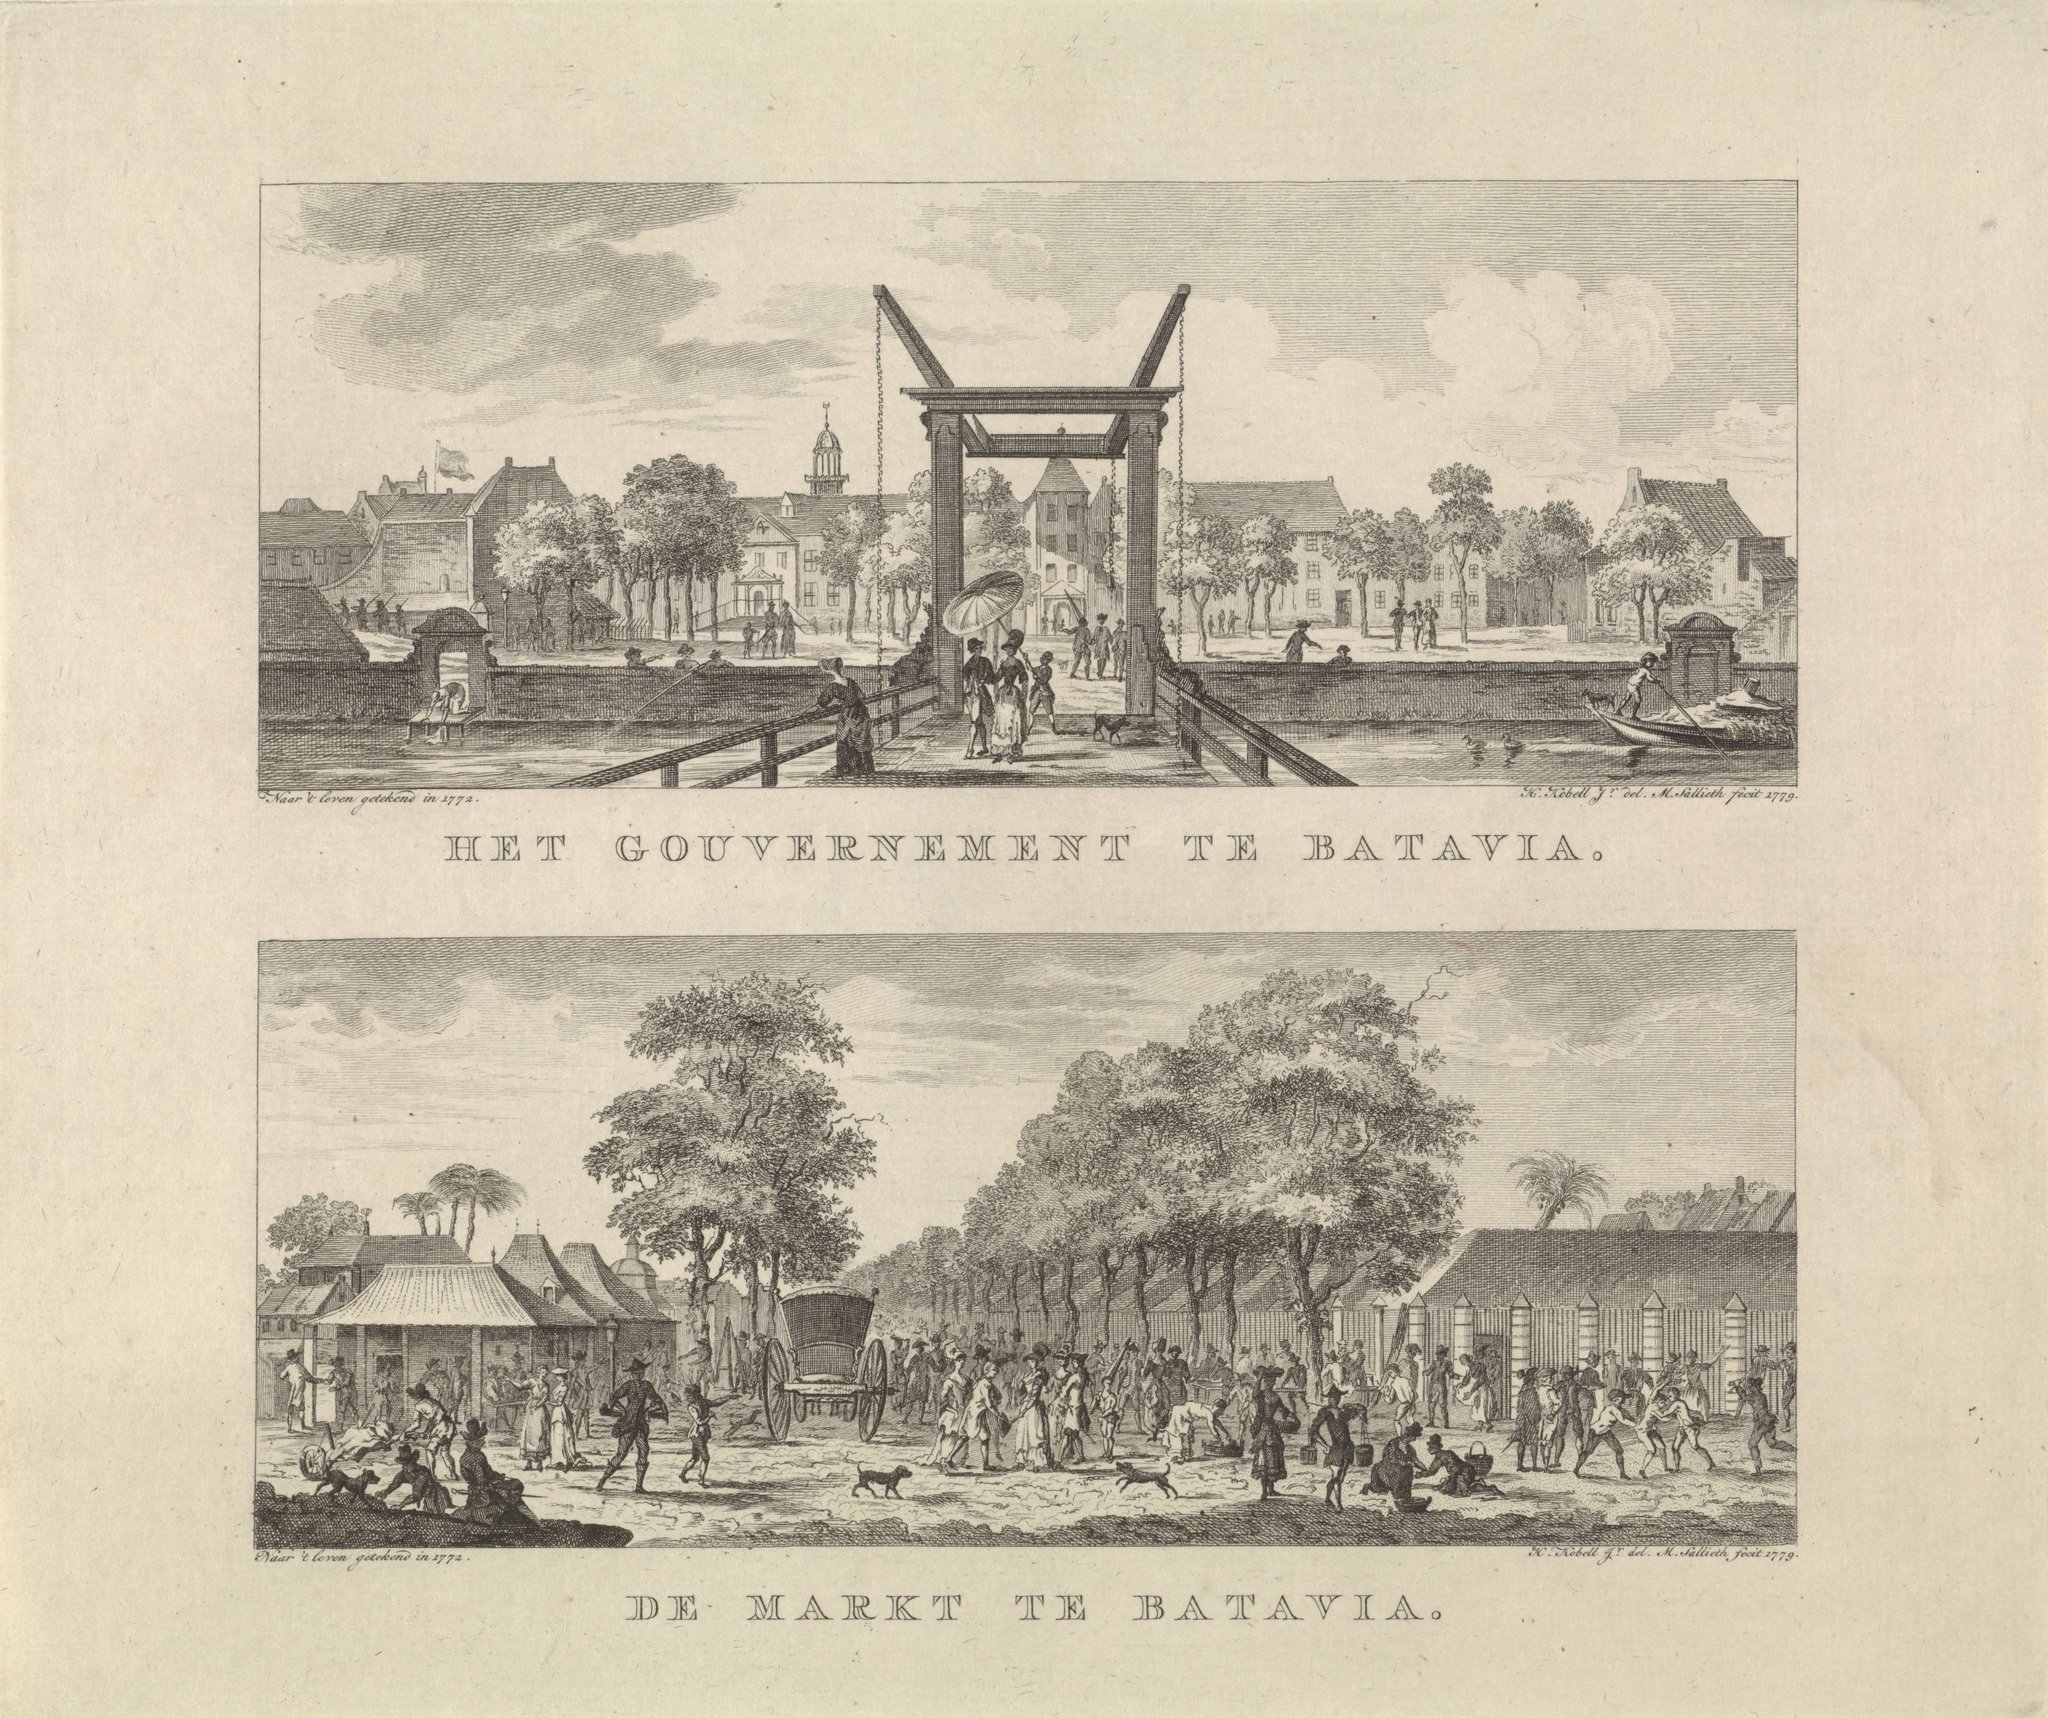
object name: print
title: Gezichten op het gouvernementsgebouw en de markt van Batavia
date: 1779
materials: paper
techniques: etching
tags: governmental and representative bodies, landscapes in the non-temperate zone, exotic landscapes, market, batavia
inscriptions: collector's mark: Lugt 2228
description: Twee voorstellingen van een plaat met gezichten op het gouvernementsgebouw (boven) en de markt van Batavia (onder).